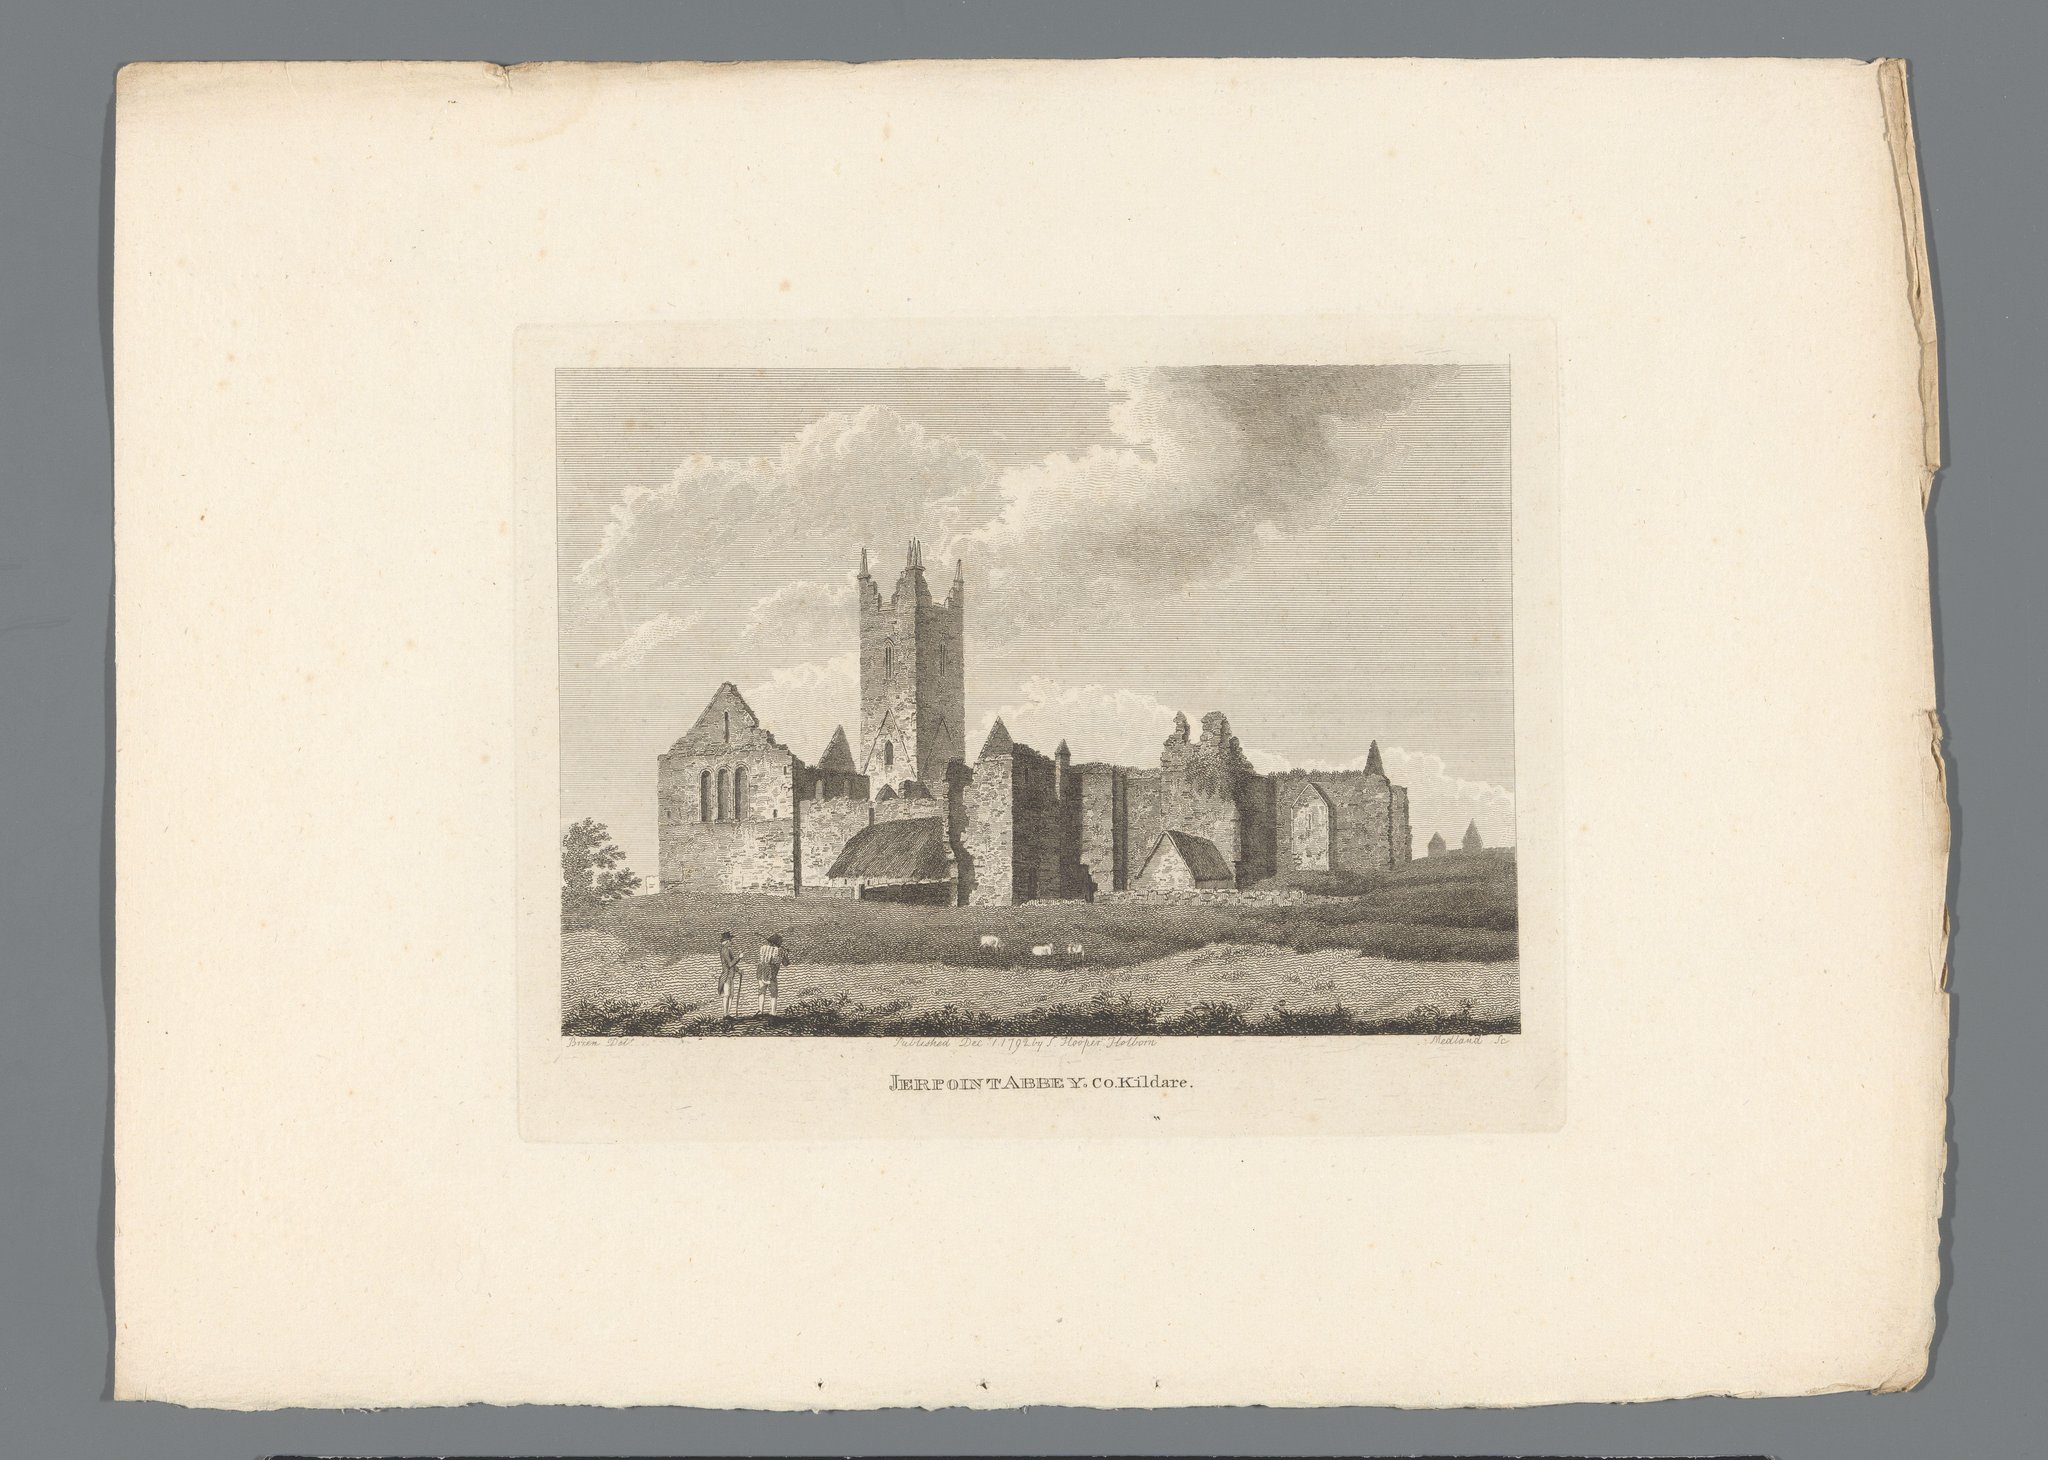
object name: print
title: Oudheden in Ierland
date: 1792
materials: paper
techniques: etching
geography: london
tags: abbey, monastery, convent ~ roman catholic church, landscape with ruins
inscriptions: mark: ‘Brien Del.’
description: Prent lijkt te horen bij RP-P-2018-3722, maar is niet in de uitgave verschenen.